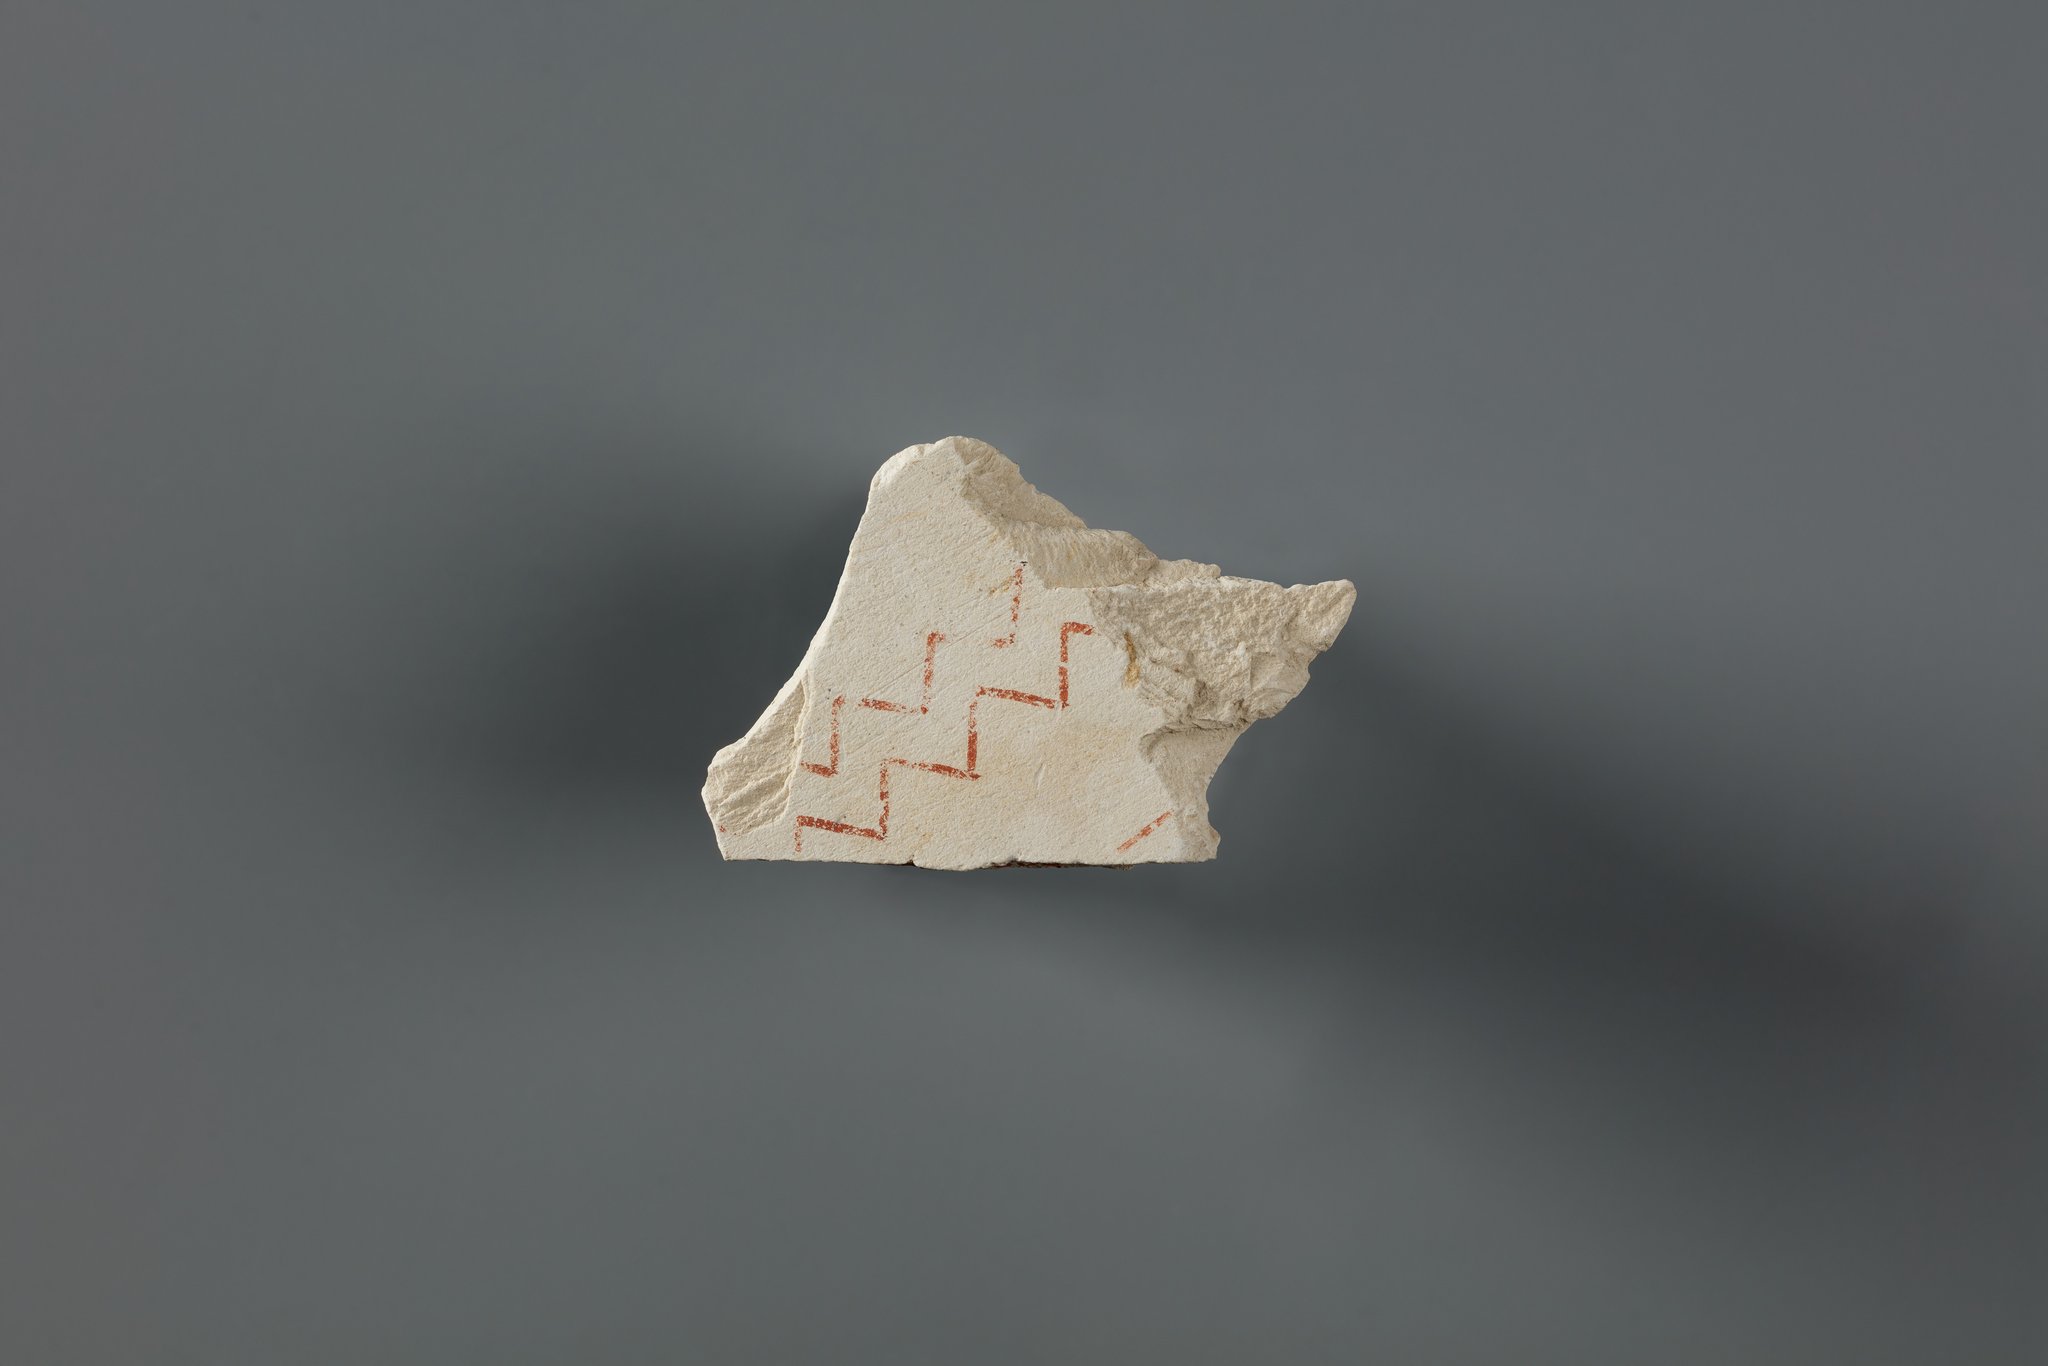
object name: relief drawing, sebeknakhte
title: Preliminary drawing for a relief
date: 2124-1504 BCE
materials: limestone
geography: egypt